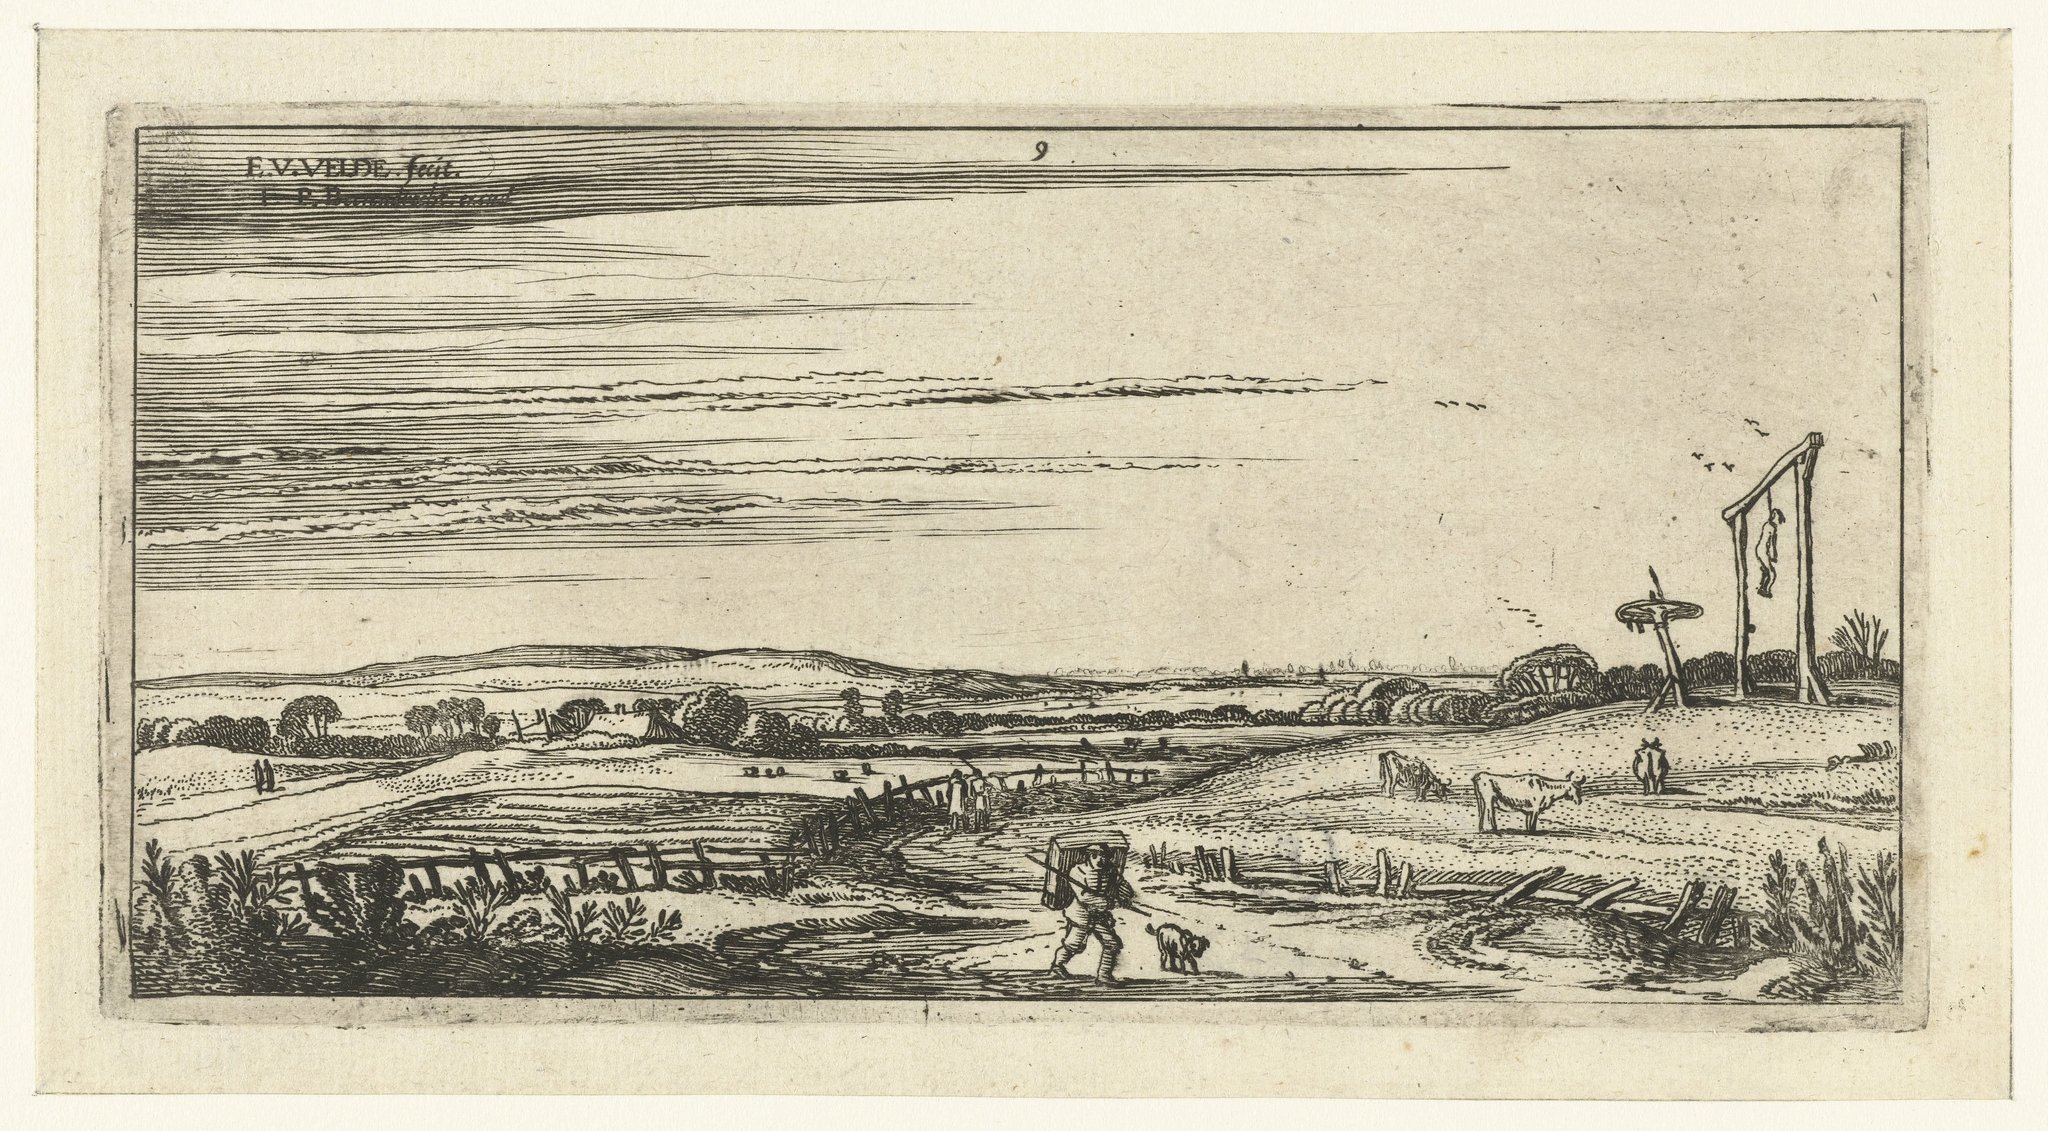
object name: print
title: Landschappen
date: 1615-1616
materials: paper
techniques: engraving, etching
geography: haarlem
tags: violent death by hanging, law and jurisprudence (+ place of execution), haarlem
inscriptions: collector's mark: Lugt 964